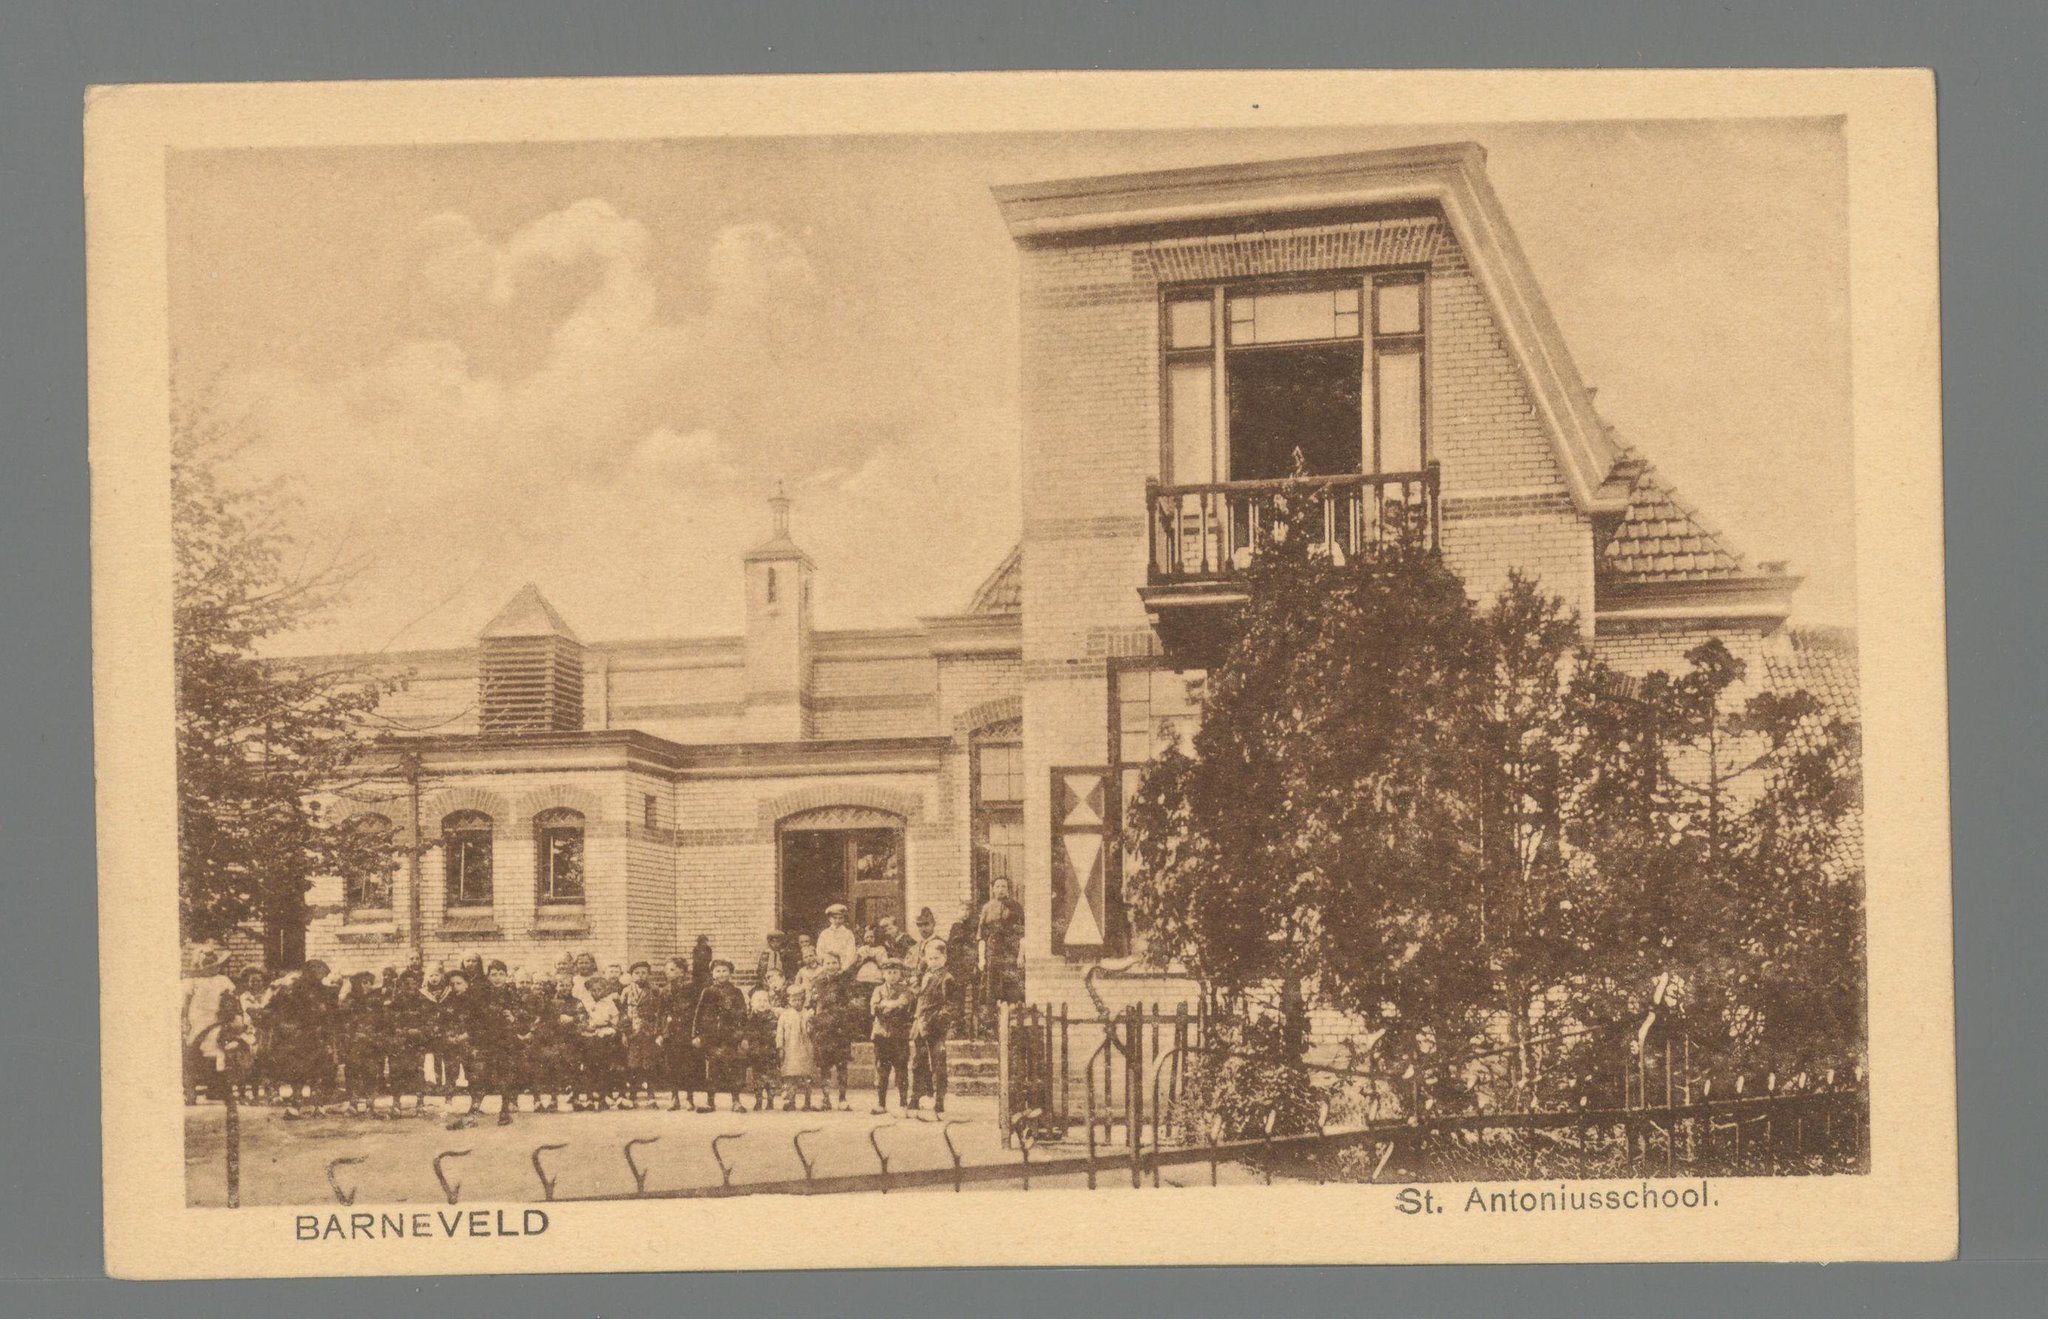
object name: photomechanical print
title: Barneveld. St. Antoniusschool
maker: Anonymous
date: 1913-1930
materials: cardboard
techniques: photograph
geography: barneveld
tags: elementary school; class, form